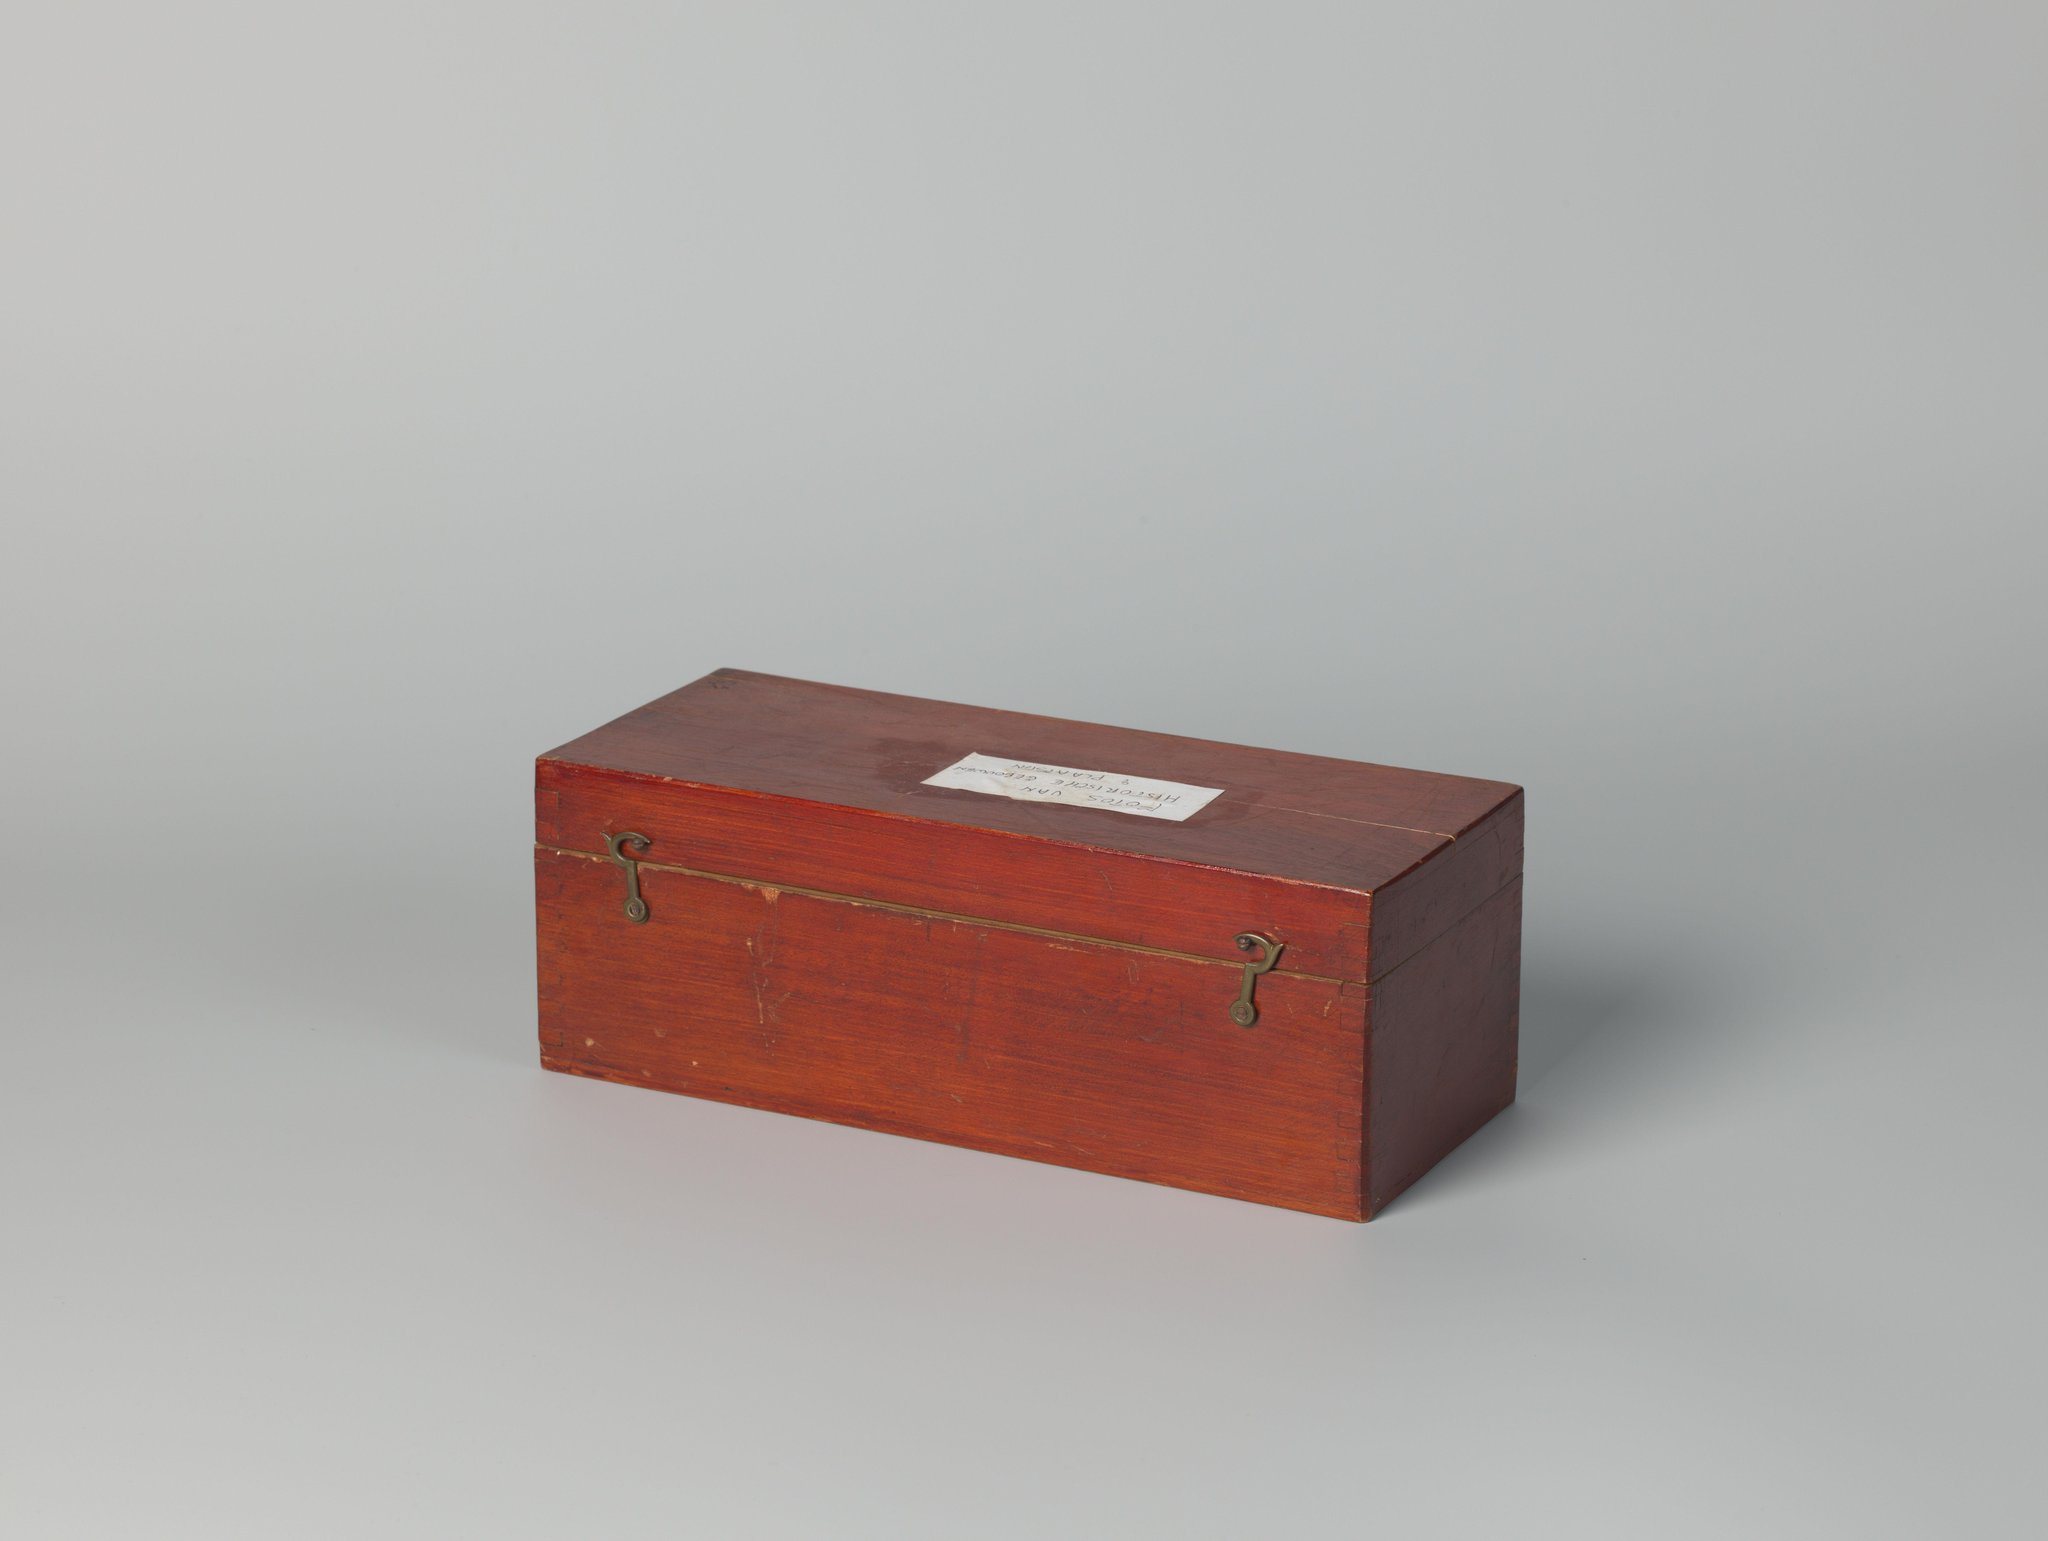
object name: chest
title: Lege houten kist voor 41 fotografische lantaarnplaatjes van de familie Kessler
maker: geldolph adriaan kessler (dolph)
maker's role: fotograaf, industrieel, voetballer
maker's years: 1884-1945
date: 1900-1910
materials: wood